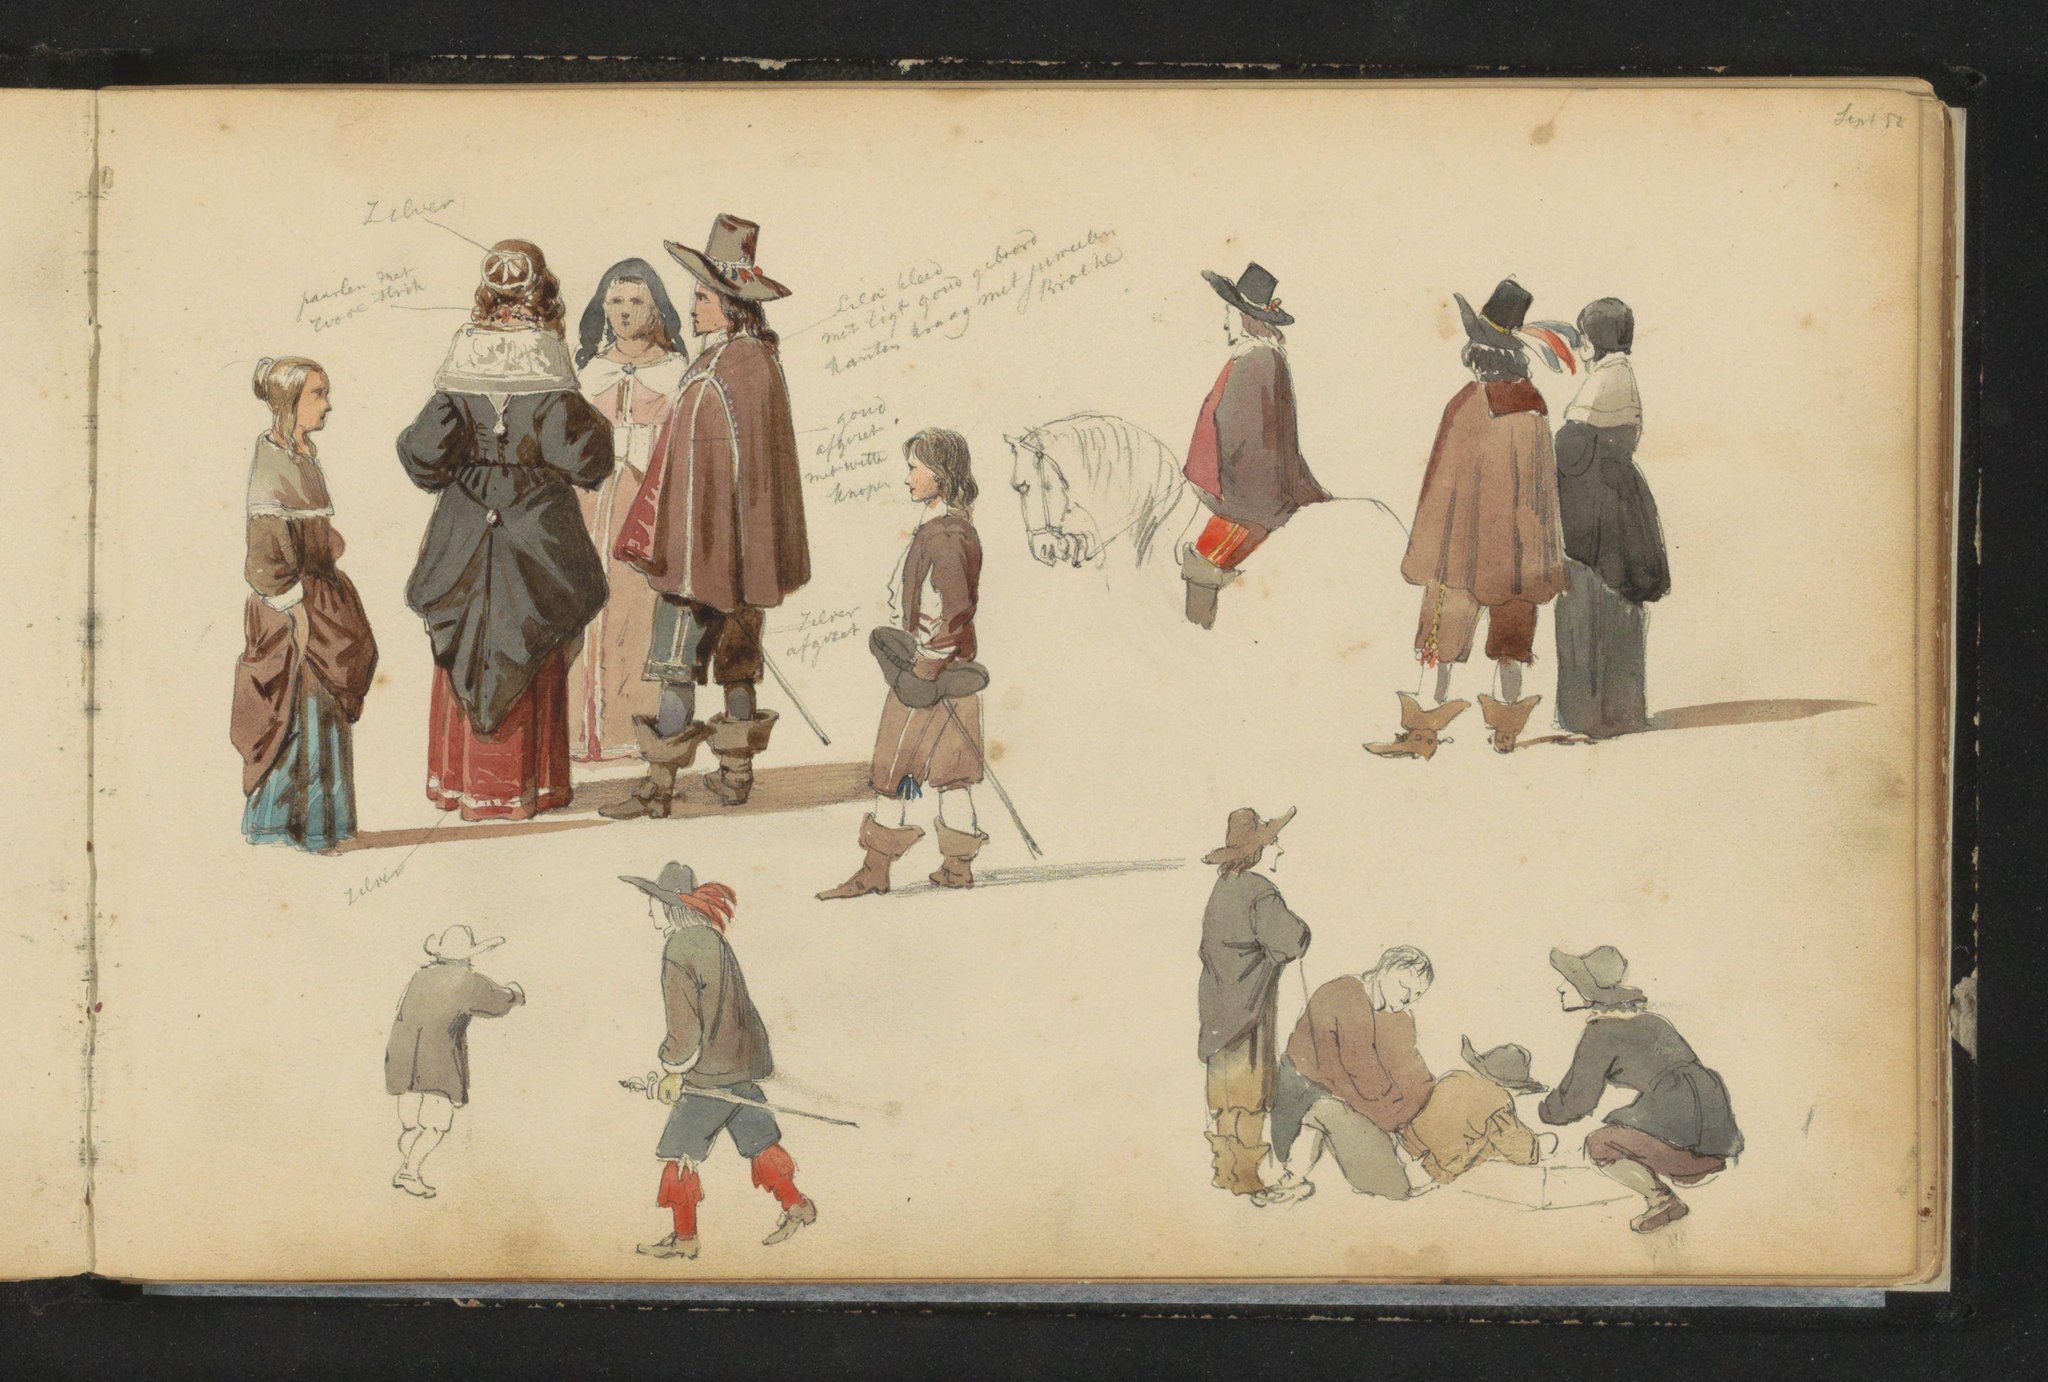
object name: sketchbook leaf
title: Figuren in zeventiende-eeuwse kleding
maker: cornelis springer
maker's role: draughtsman, painter, print maker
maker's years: 1817-1891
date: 1809-1852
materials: paper, pencil, watercolor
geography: netherlands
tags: adult woman, adult man, child, pedlar, clothes, costume (+ women's clothes), clothes, costume (+ men's clothes)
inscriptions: date: ‘Sept 52’, annotation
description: Figuren, onder andere marskramers, in zeventiende-eeuwse kleding. Rechtsboven een man te paard. Blad 15 uit een schetsboek met 91 bladen.